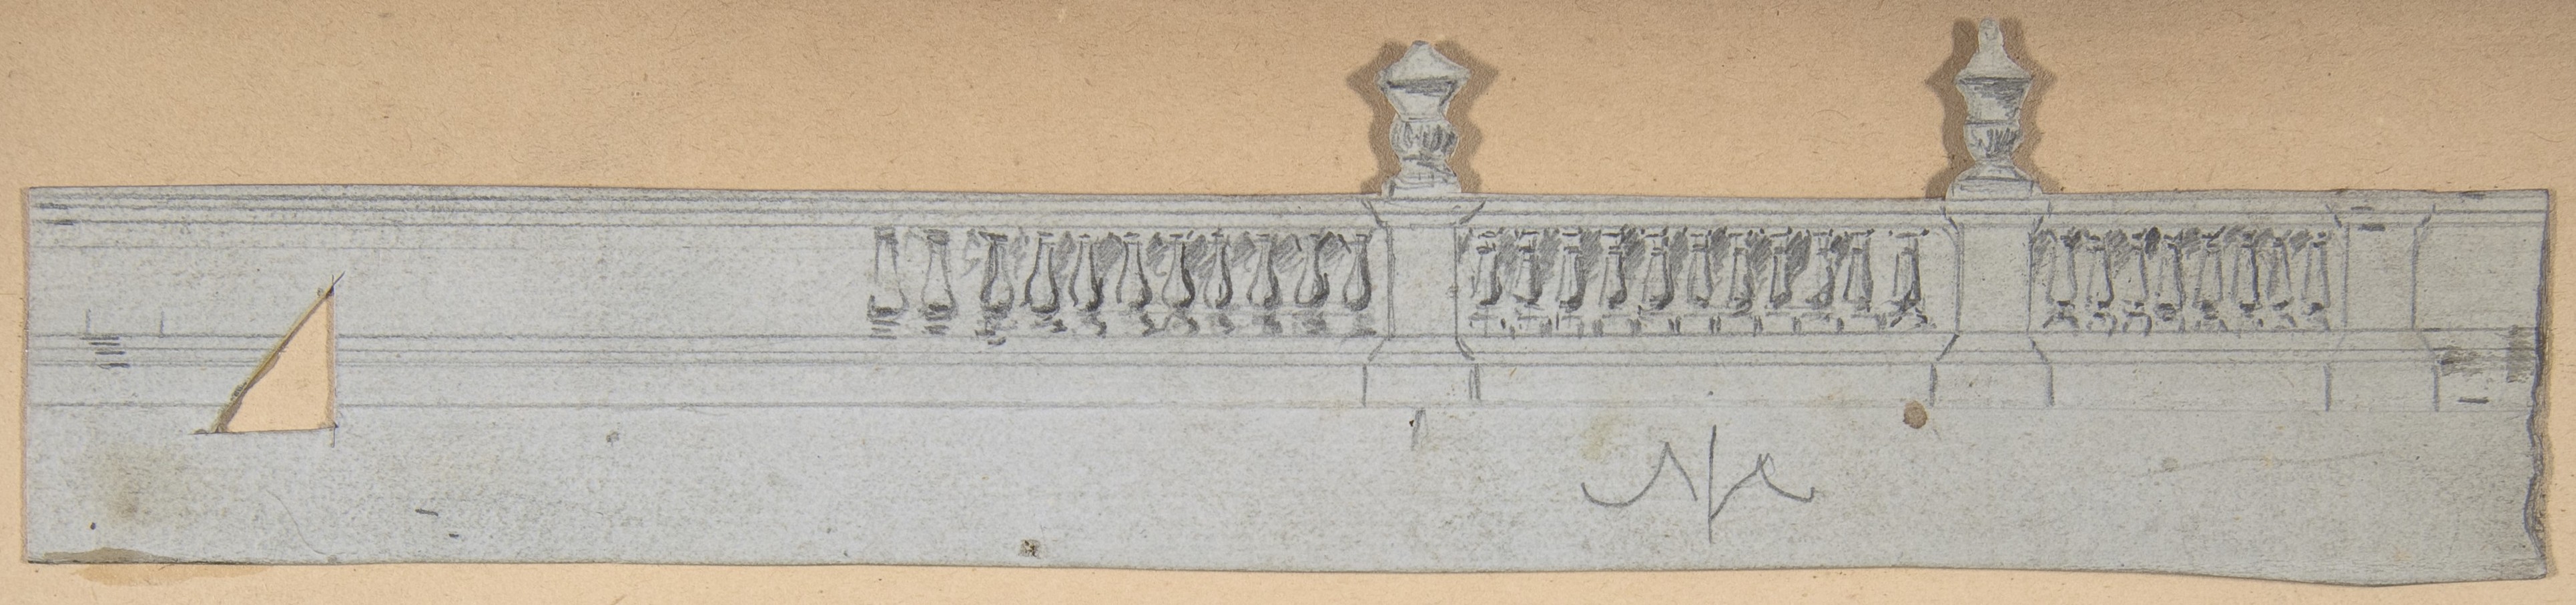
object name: drawing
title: Design for a Stage Set at the Opéra, Paris: Balustrade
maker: eugène cicéri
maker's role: artist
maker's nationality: french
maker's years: 1813-1890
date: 1830-1890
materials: graphite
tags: stage design